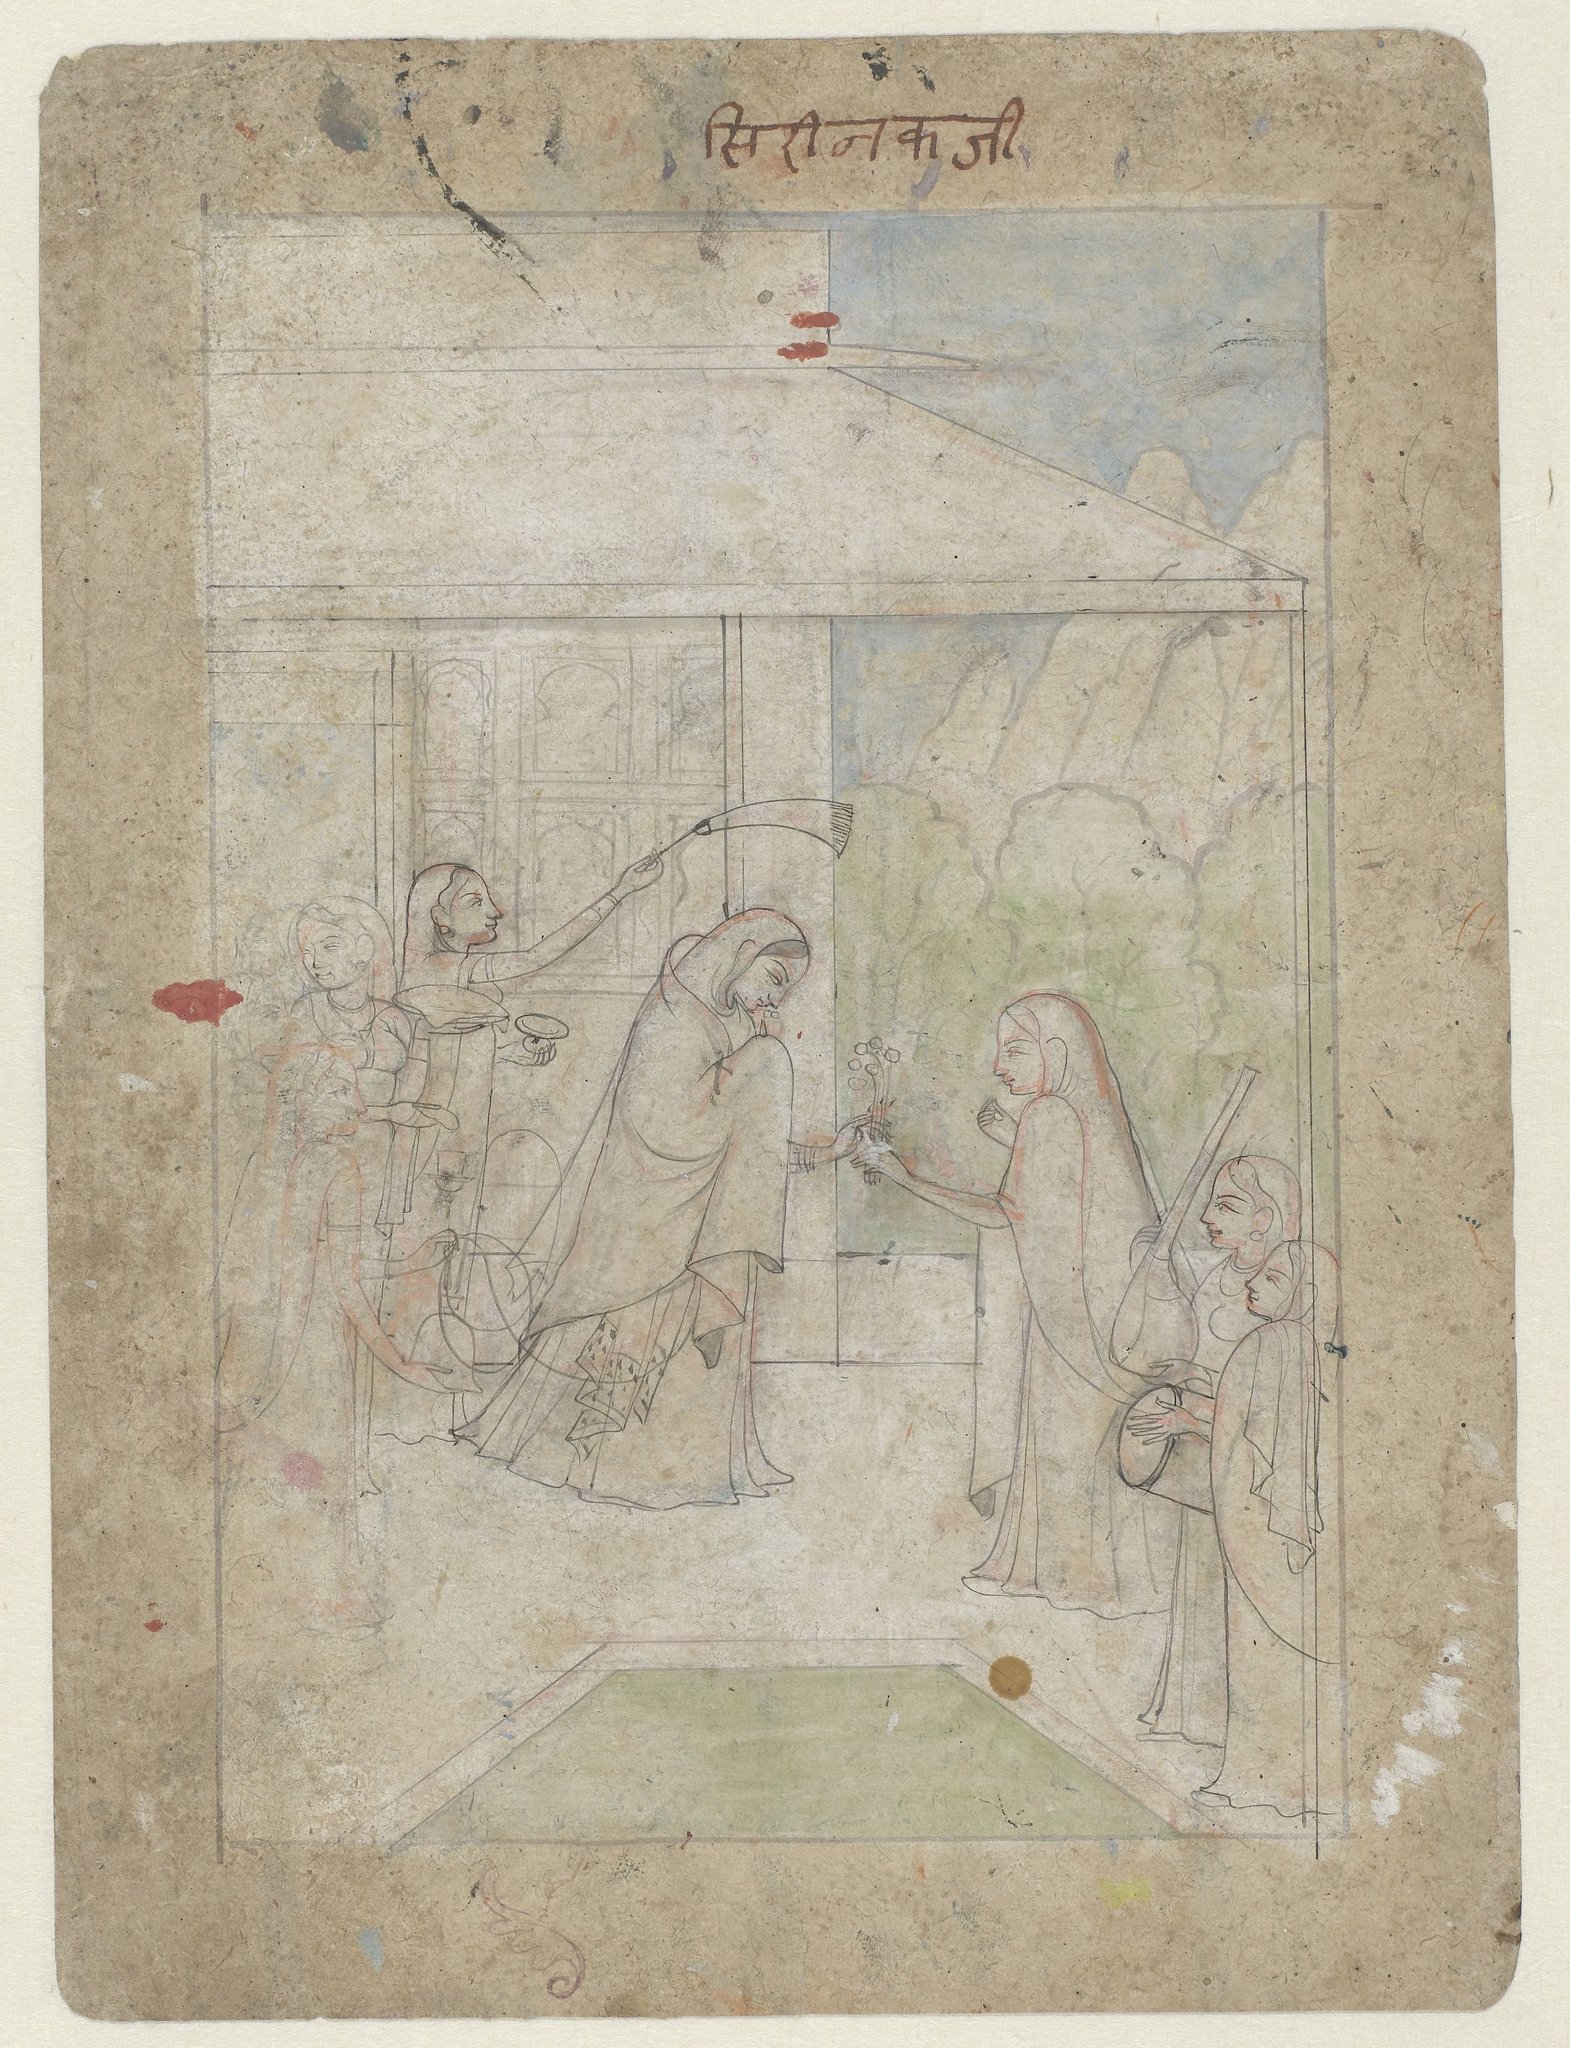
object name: indian miniature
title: Prinses ontvangt bloemen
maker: Anonymous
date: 1800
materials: paper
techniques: brush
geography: kangra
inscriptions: inscription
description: Een prinses staat op het terras van het paleis en terwijl achter haar een dienares haar koelte toewuift met een waaier en andere dienaressen schotels vasthouden reikt een vrouw voor haar een bosje bloemen aan, zij wordt vergezeld door twee dames die een tampoera en een trommel vasthouden. De voorstelling is omlijst door kaderlijnen in lichtgrijs.